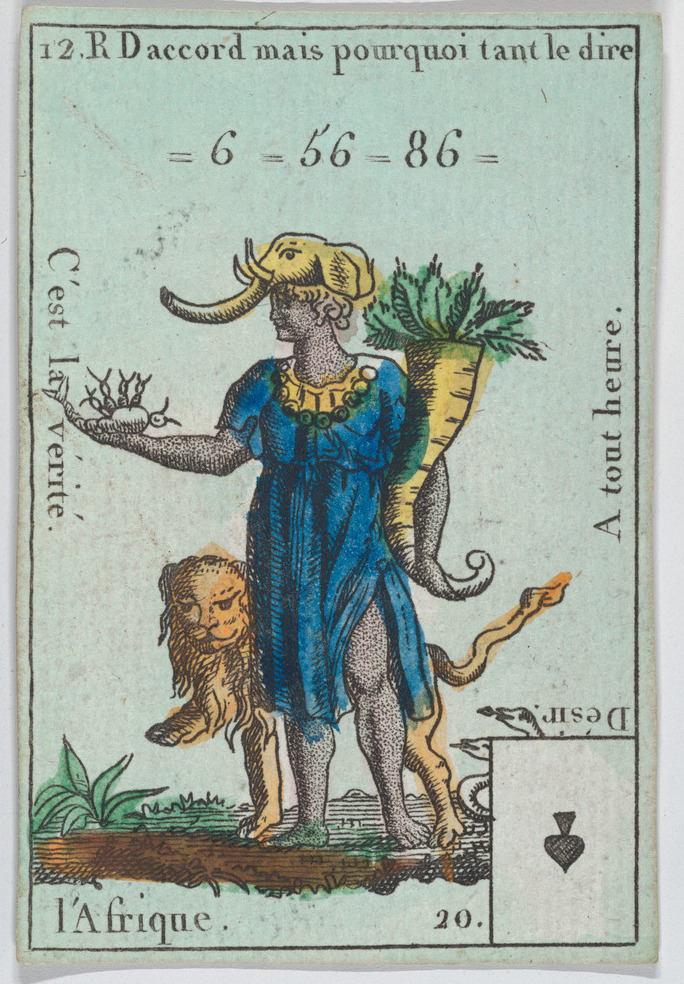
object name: print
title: L'Afrique from playing cards "Jeu d'Or"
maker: anonymous, french, 18th century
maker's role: artist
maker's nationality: french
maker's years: 1700-1800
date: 1700-1799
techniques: etching, hand coloring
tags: women,playing cards,lions,cornucopia